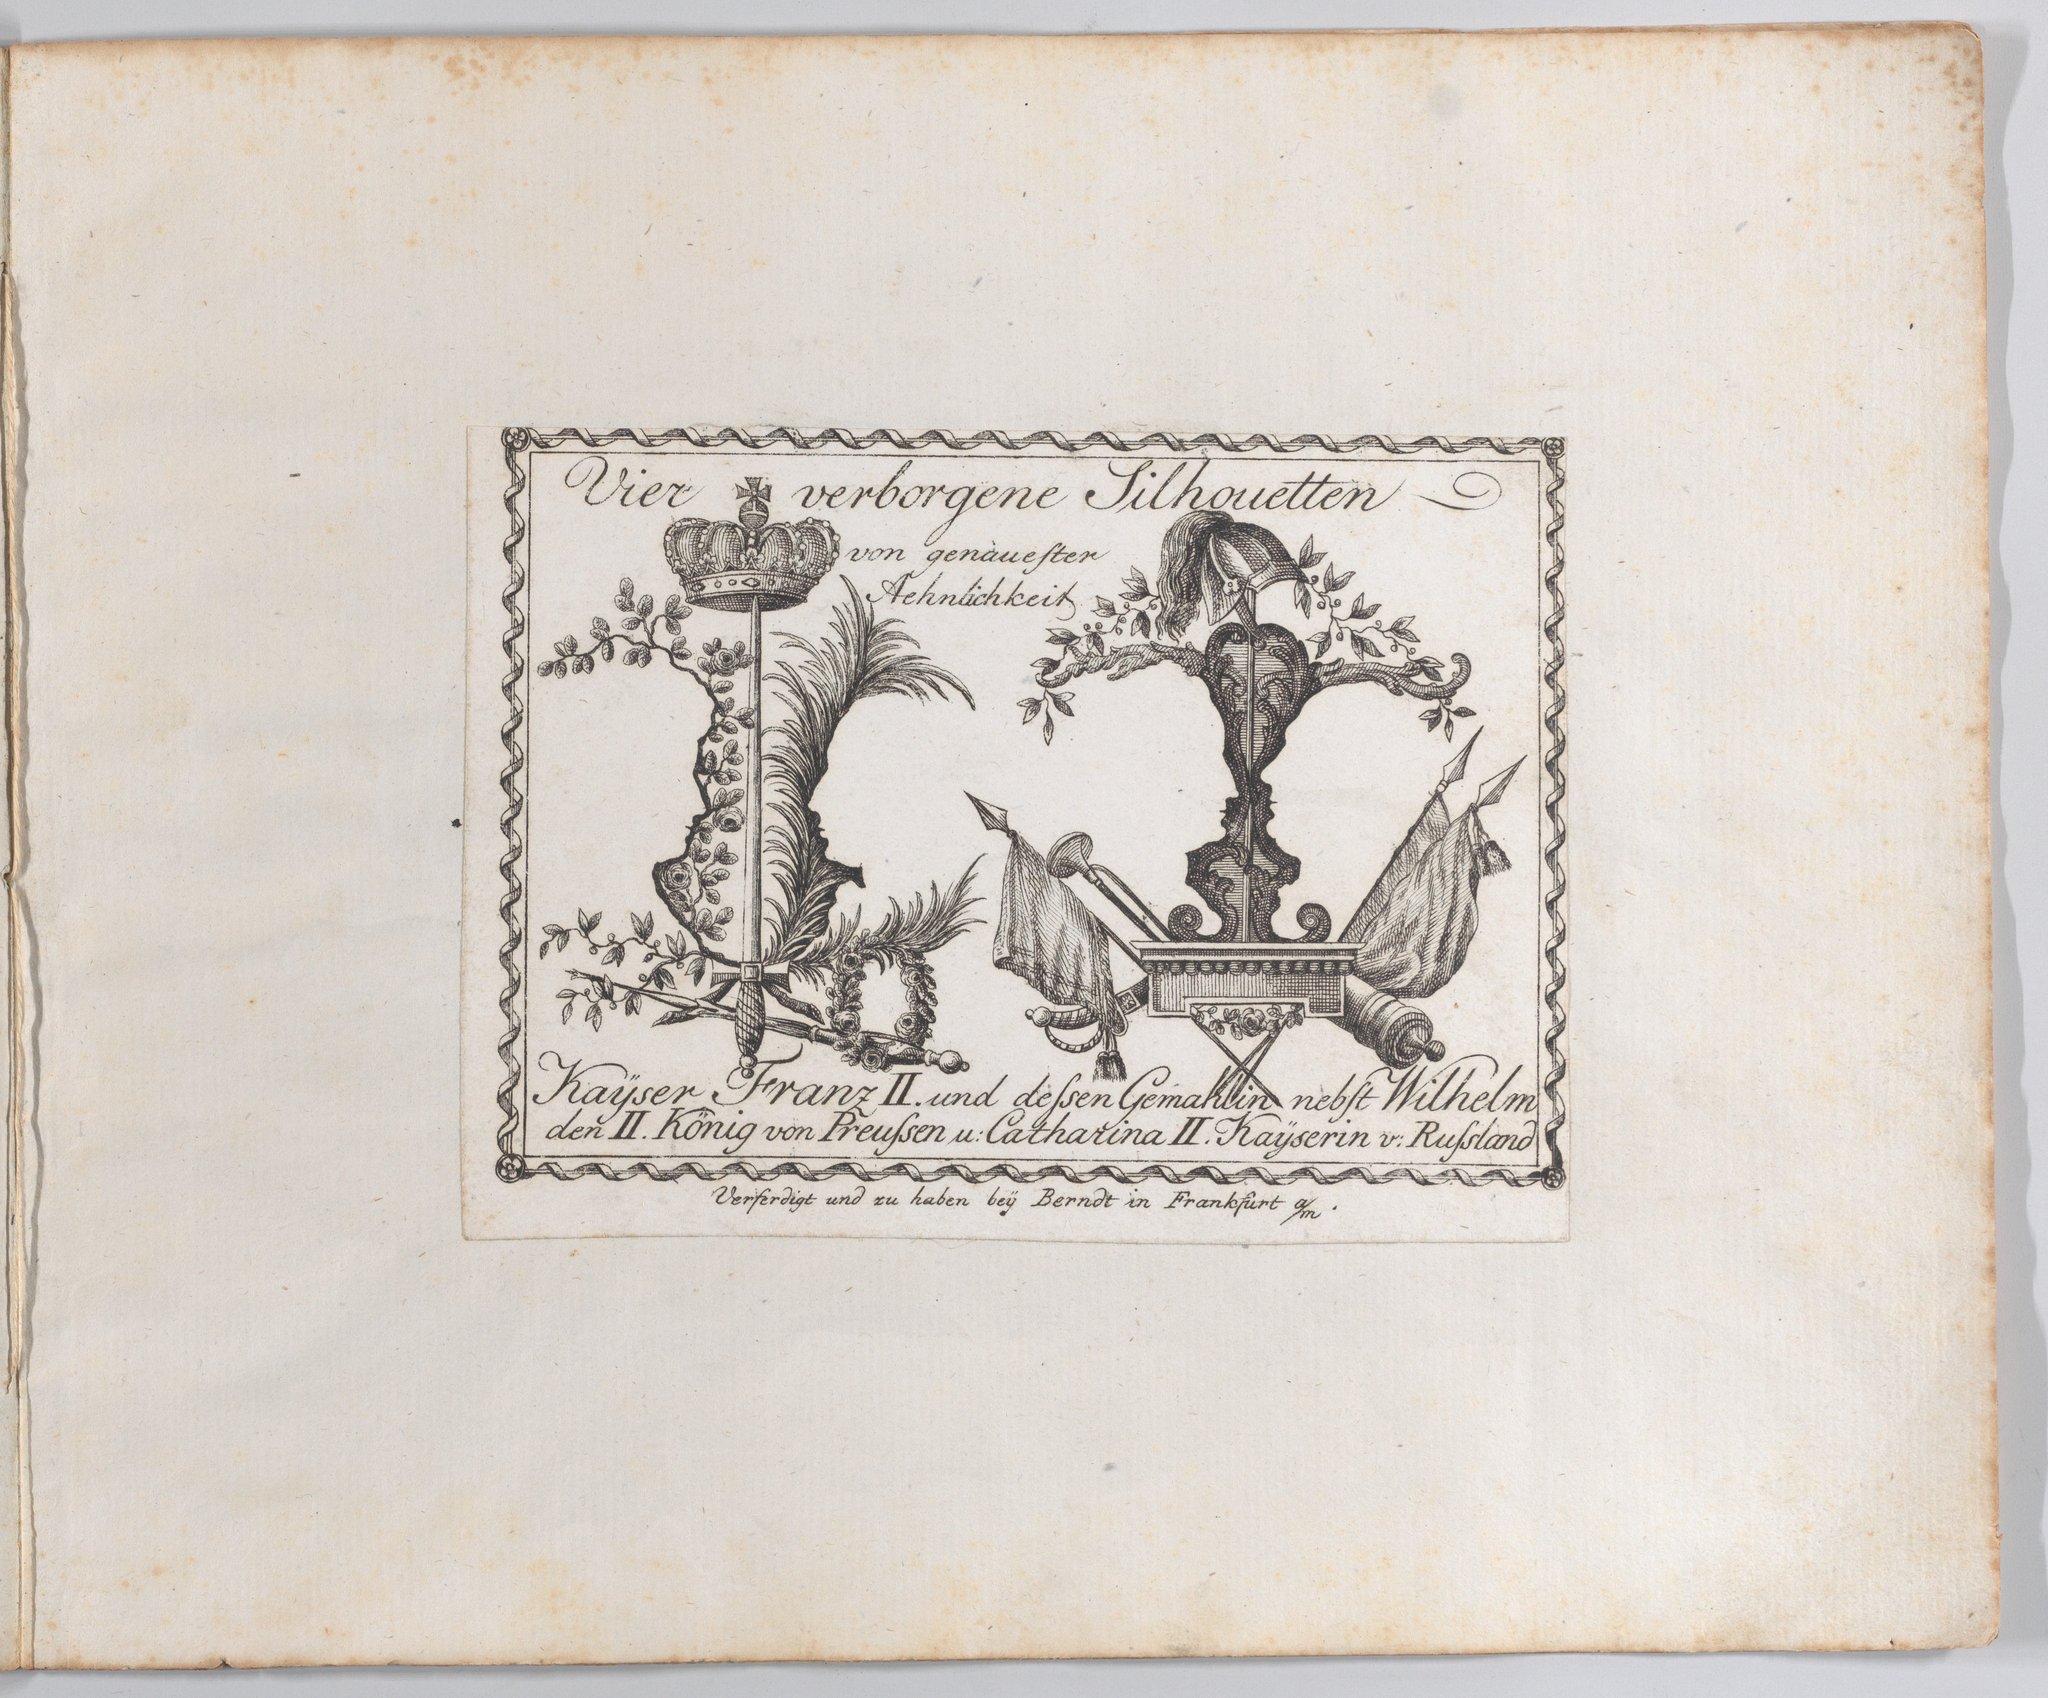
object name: album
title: Landscape containing four silhouettes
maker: anonymous, german, 18th century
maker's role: artist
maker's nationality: german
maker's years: 1700-1800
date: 1793-1800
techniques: etching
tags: emperors,kings,crowns